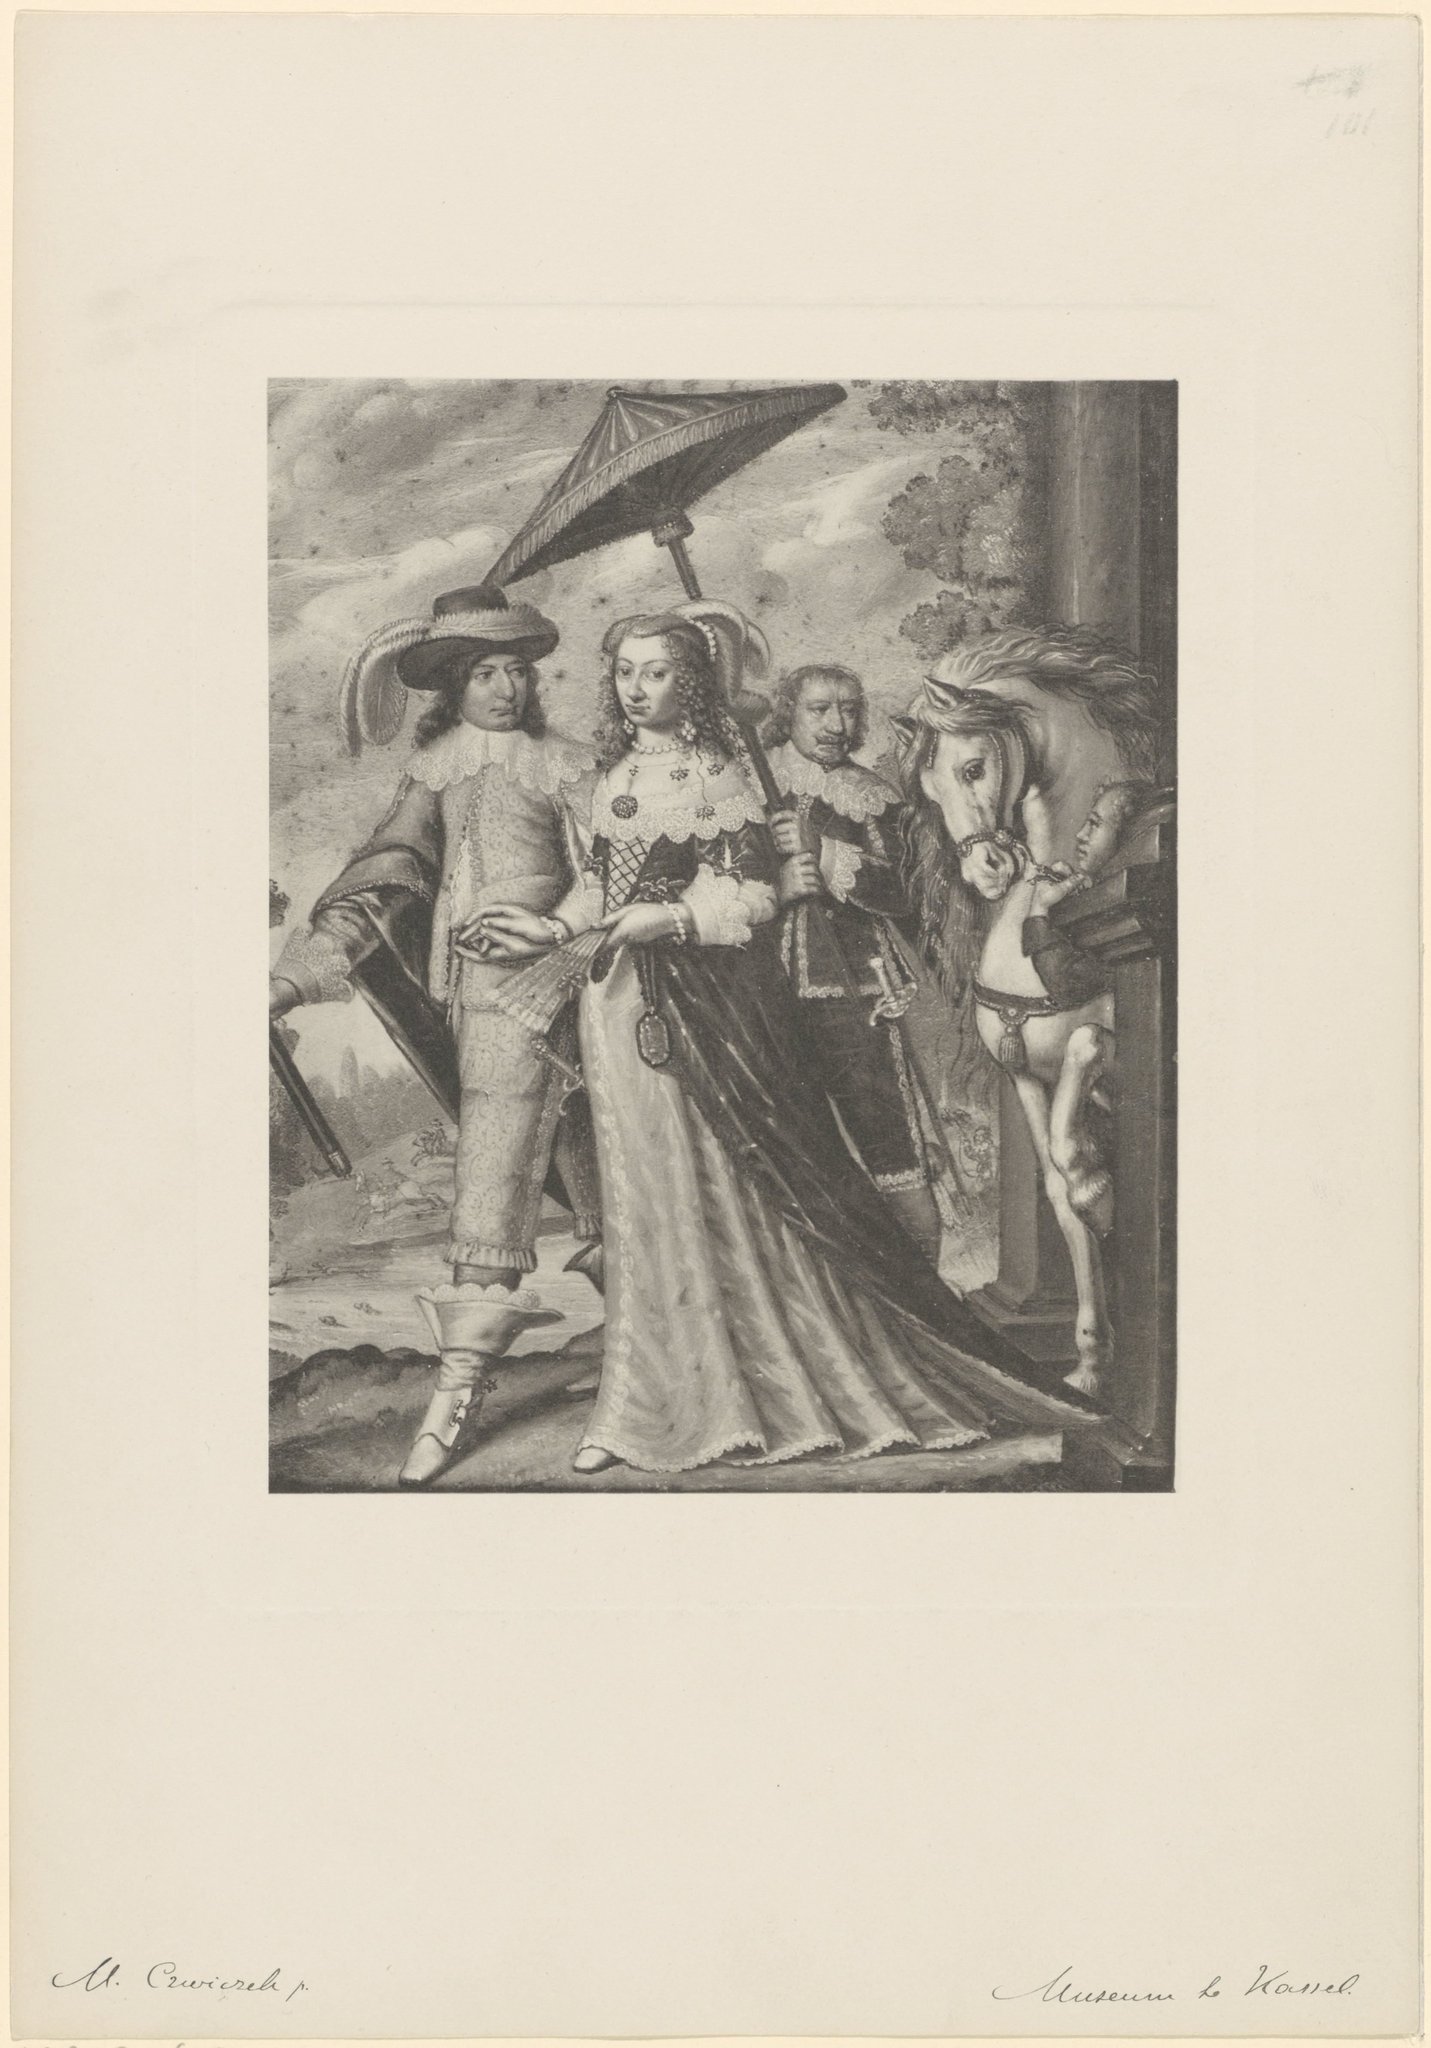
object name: photomechanical print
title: Portret van Louise Henriëtte, prinses van Oranje, en Frederik Willem van Brandenburg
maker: Anonymous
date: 1850-1949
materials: paper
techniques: photograph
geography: netherlands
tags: frederik willem van brandenburg (i), louise henriëtte (prinses van oranje)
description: De hier vermelde titel verwijst naar de hoogst verkregen titel van de geportretteerde, niet per se naar de titel die de geportretteerde op deze voorstelling draagt.